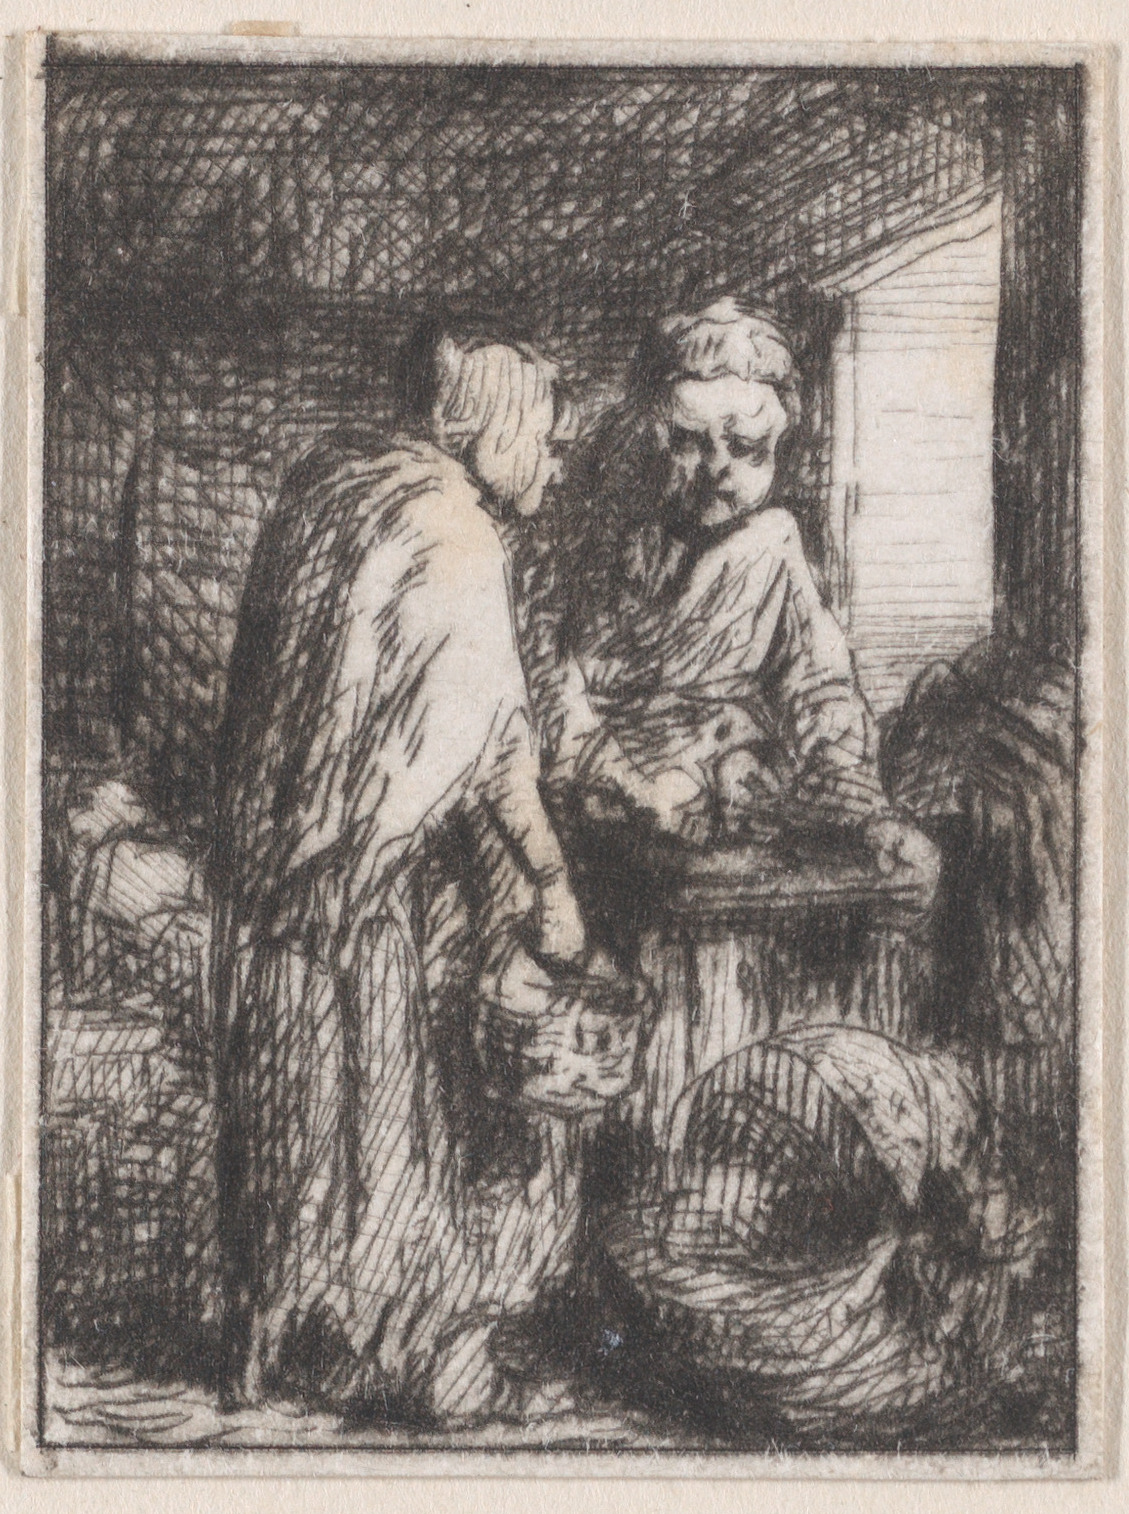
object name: print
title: Fruit Seller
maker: charles émile jacque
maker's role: artist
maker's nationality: french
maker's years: 1813-1894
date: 1843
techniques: drypoint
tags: fruit,women